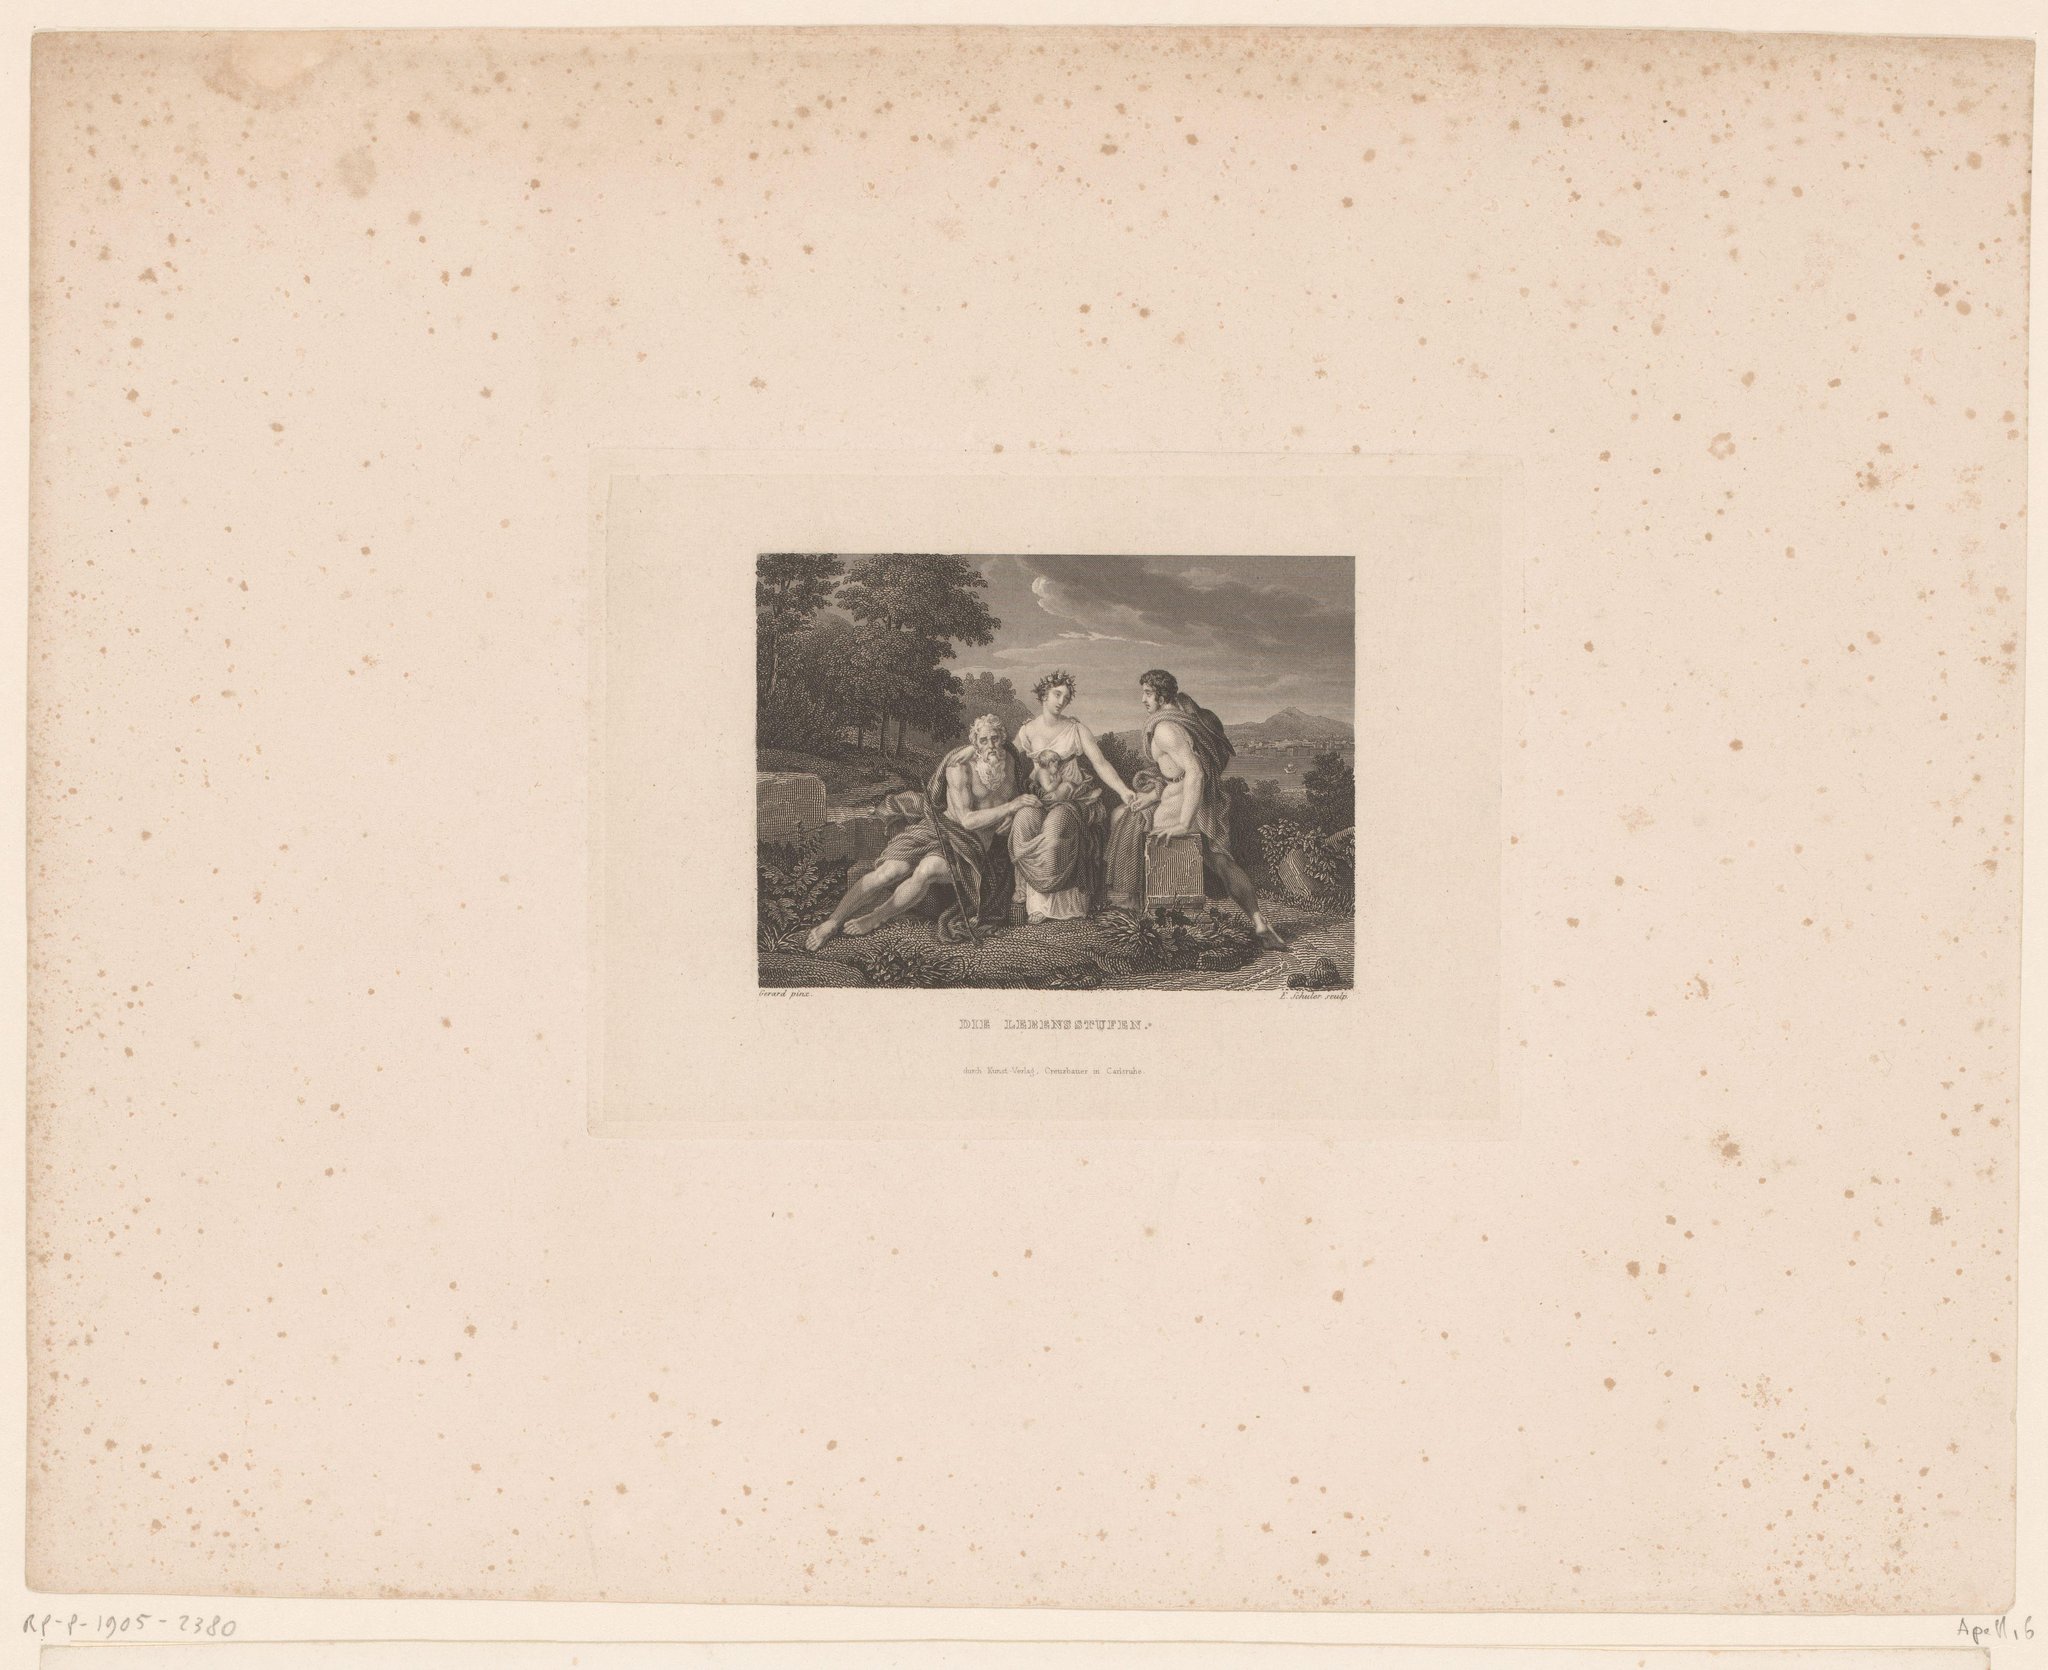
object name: print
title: Personificaties van de levensfasen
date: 1816-1882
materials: paper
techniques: engraving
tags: human life divided into stages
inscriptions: collector's mark: Lugt 2228